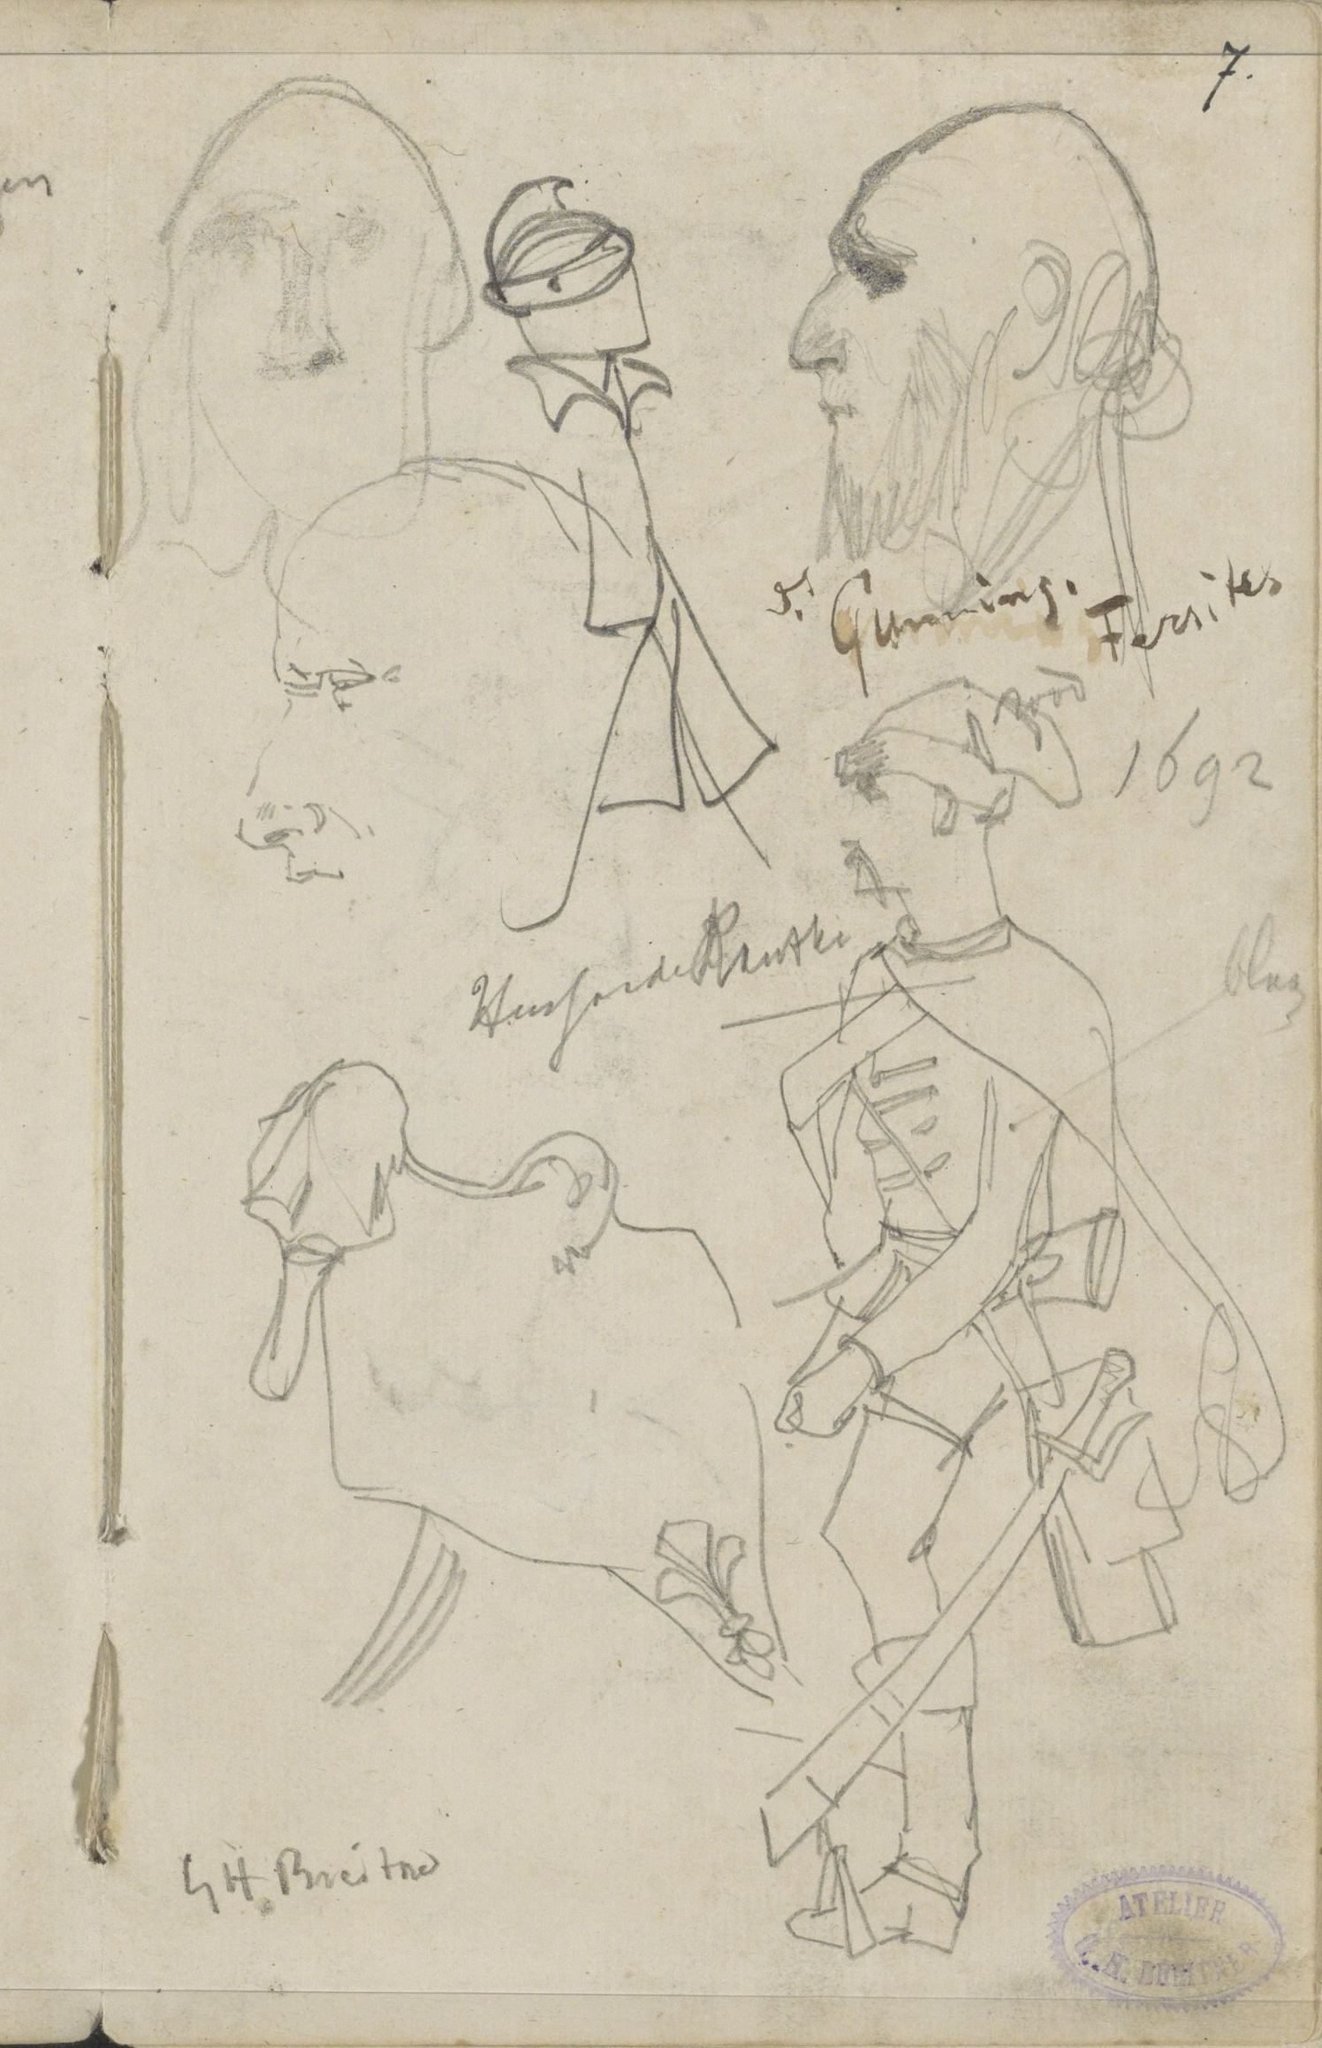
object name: sketchbook leaf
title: Studieblad met een huzaar, een zadel en mannenhoofden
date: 1880-1882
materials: paper, pencil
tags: head (human), division of armed forces (+ cavalry, horsemen), saddle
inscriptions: :, workshop stamp: Lugt 291d, annotation: ‘[...]/ Gunning./ Fersites/ Hussarde [...]’, signature: ‘G.H. Breitner’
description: De huzaar draagt een uniform uit 1625 en heeft een voet in een stijgbeugel. Blad 7 recto uit een schetsboek met 16 bladen.